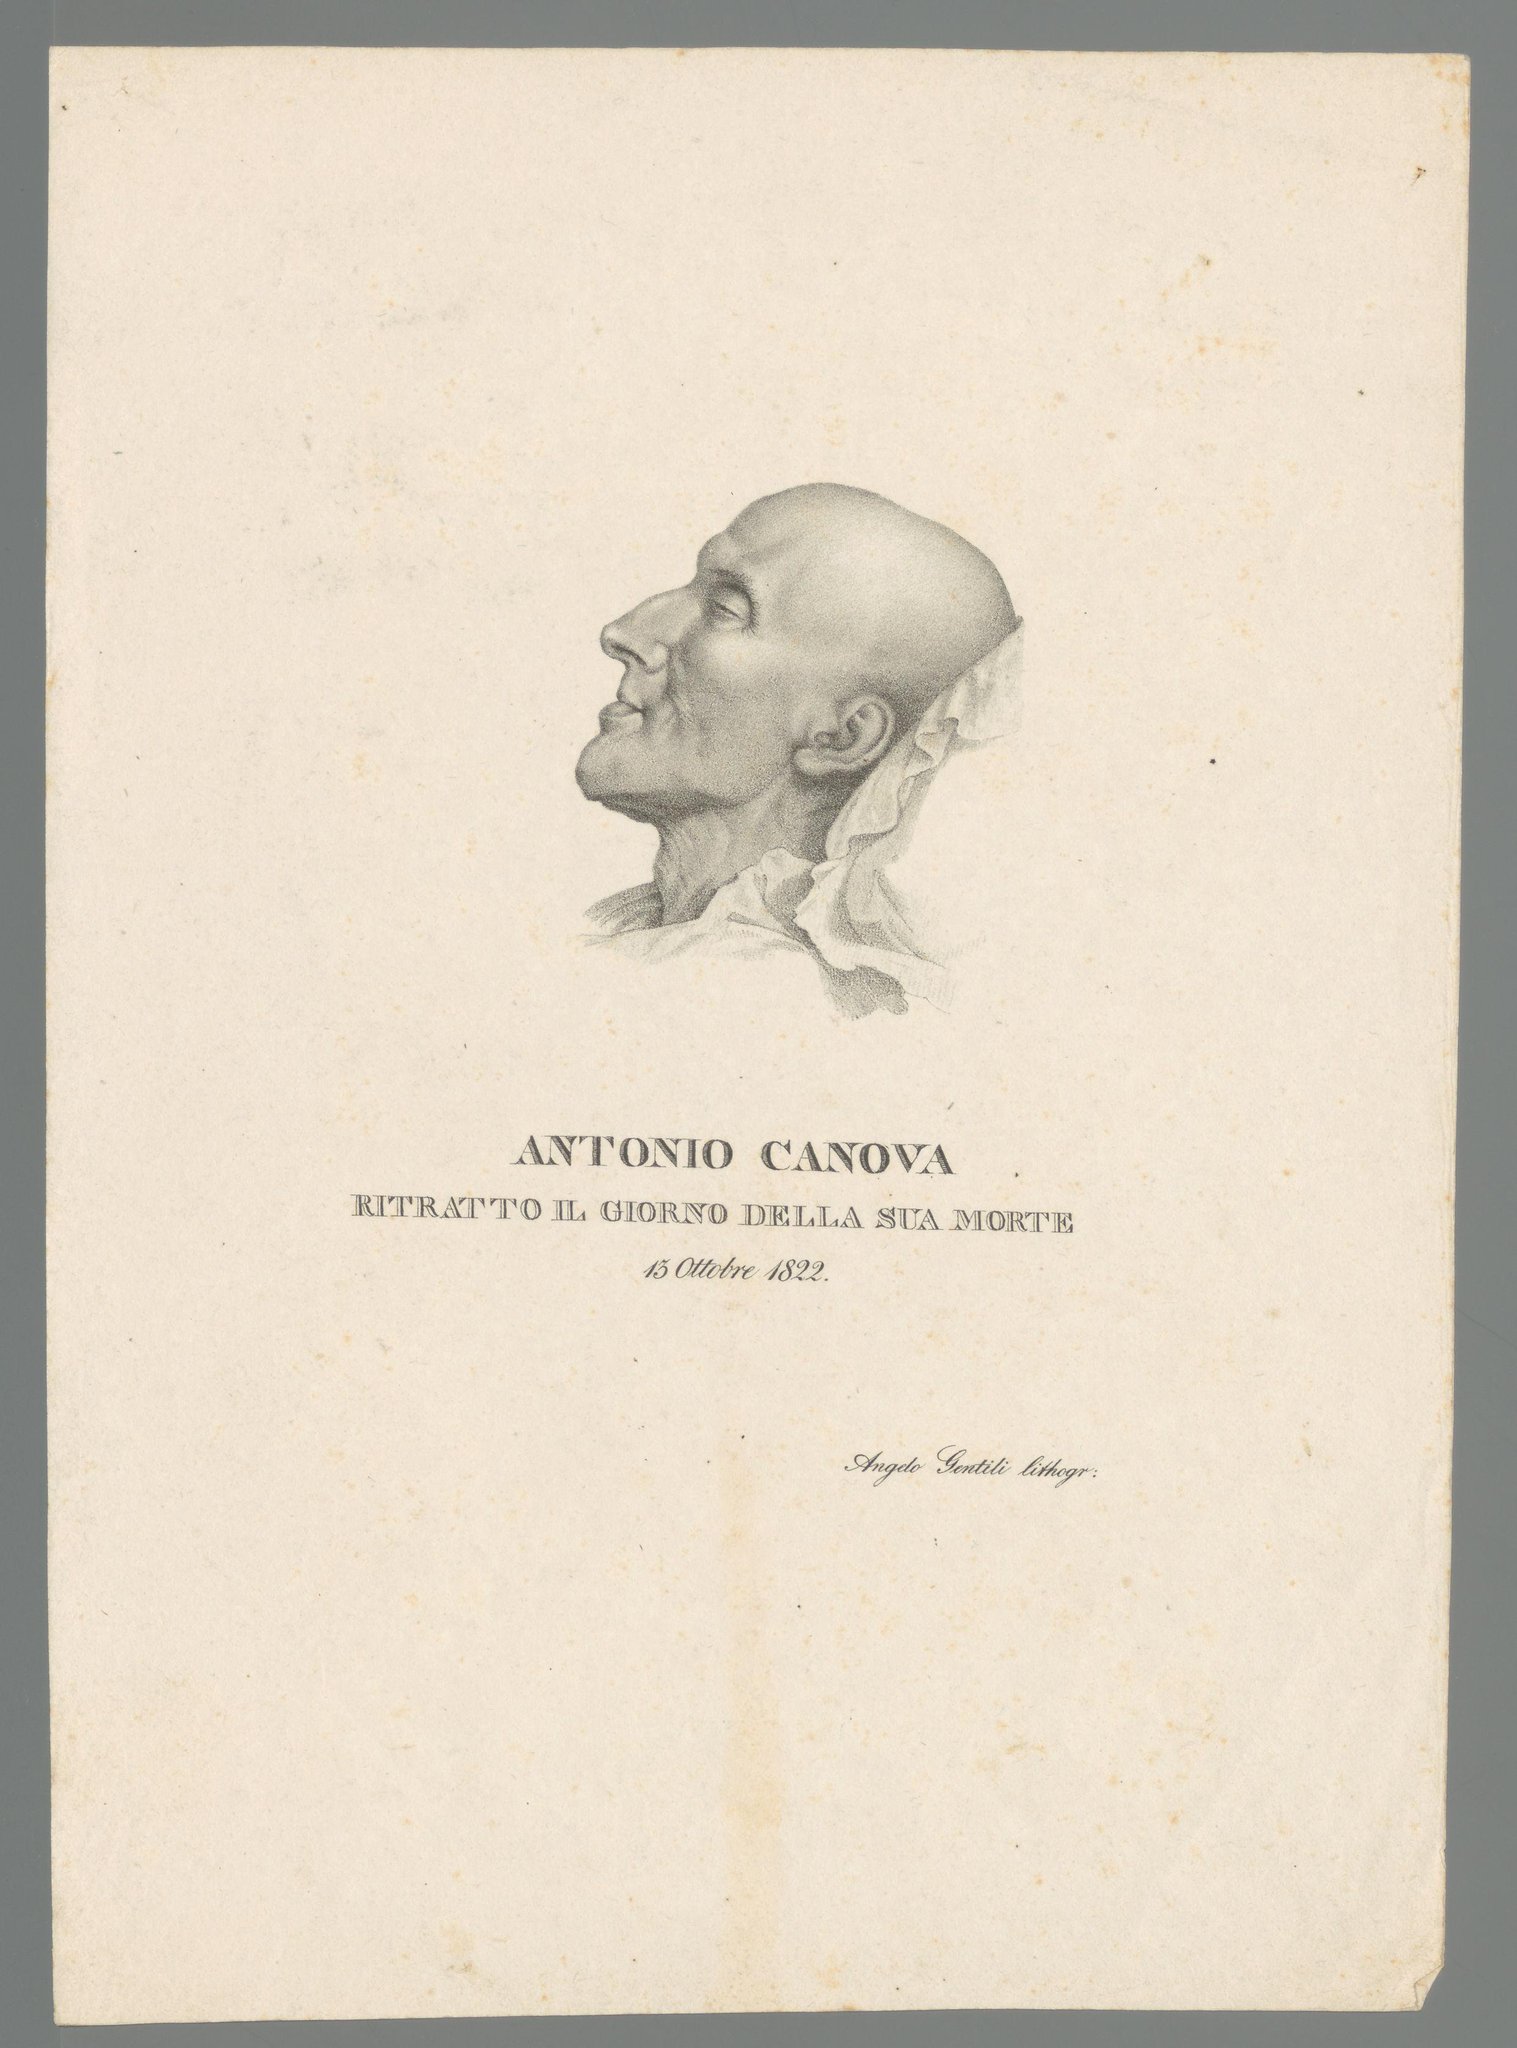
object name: print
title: Antonio Canova, ritratto il giorno della sua morte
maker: angelo gentili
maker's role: print maker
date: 1826-1840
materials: paper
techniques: lithograph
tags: venice, painter, draughtsman, antonio canova, deathbed, historical persons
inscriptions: collector's mark: Lugt 2228